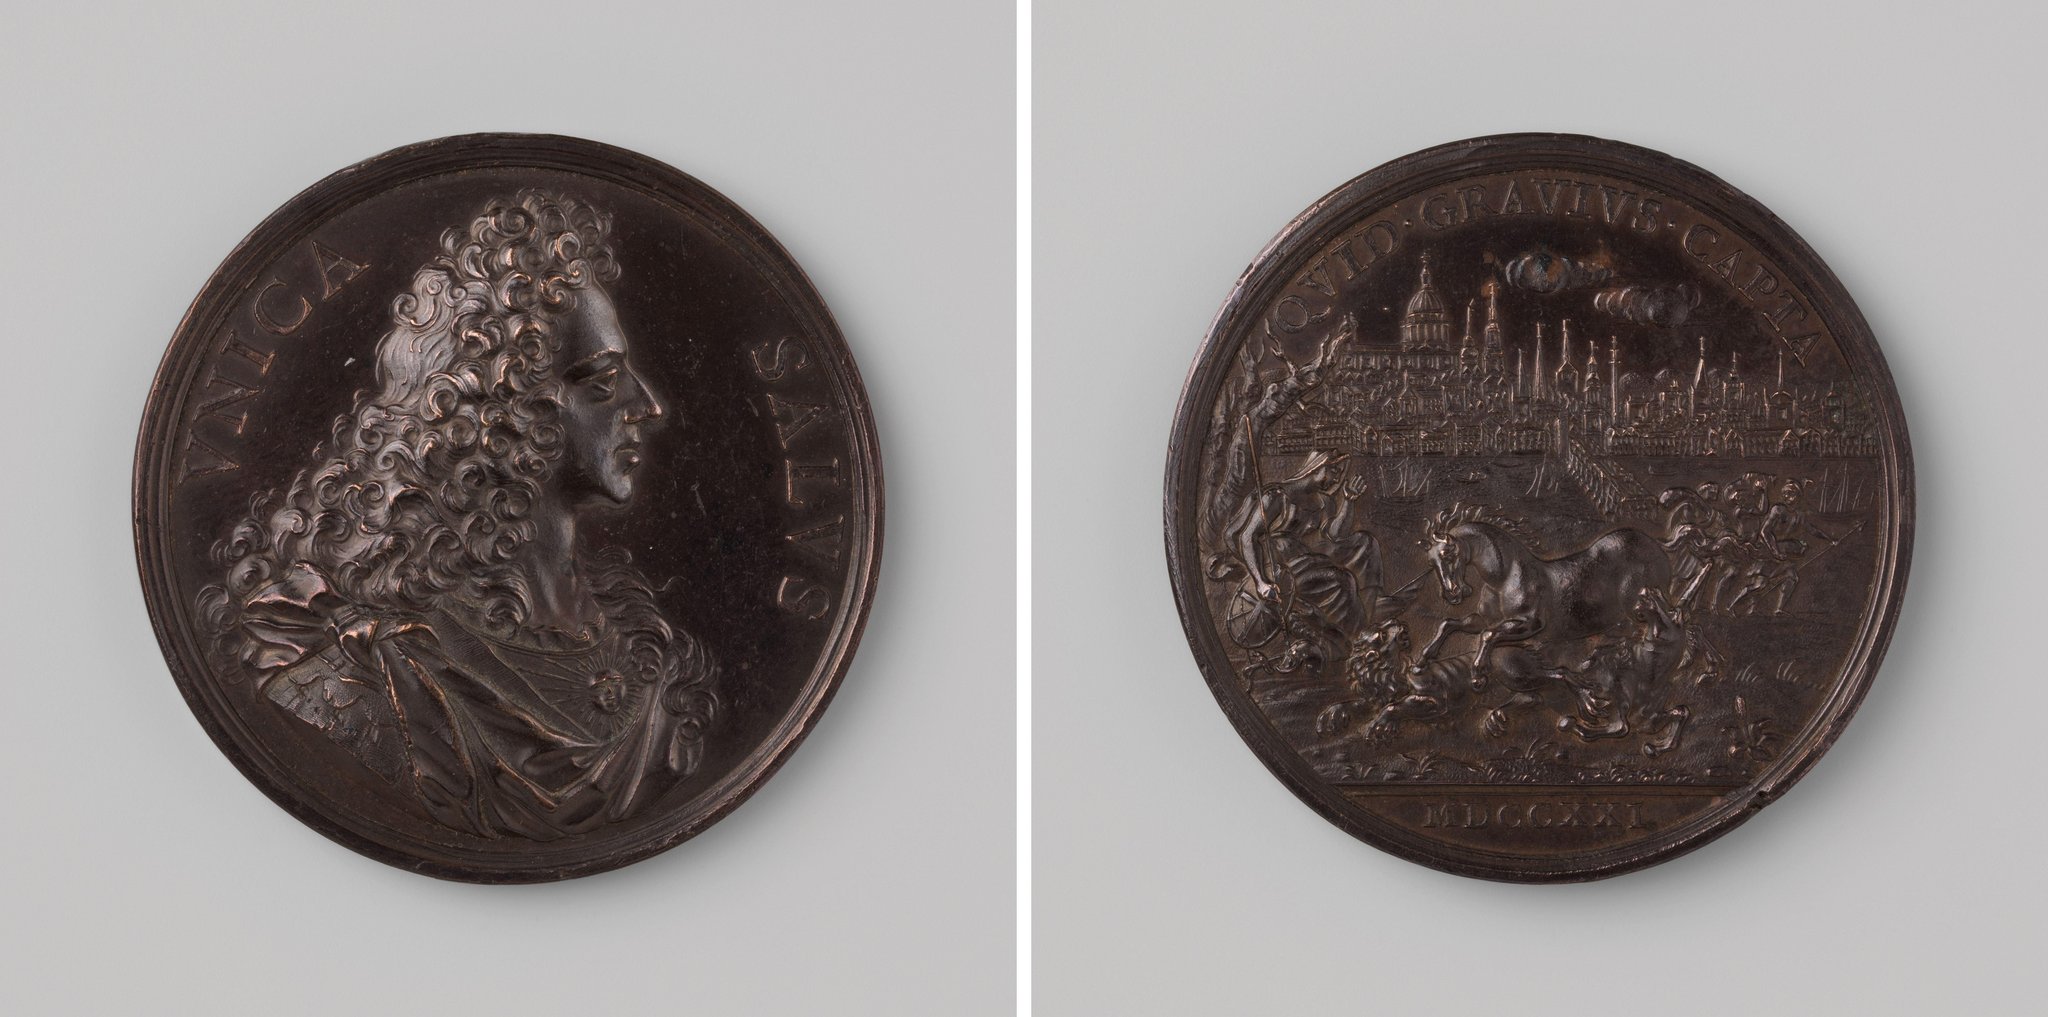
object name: history medal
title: Protest van Jacobus III Stewart, de 'Old Pretender' tegen de heerschappij van het huis van Hannover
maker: ottone hamerani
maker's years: 1694-1768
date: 1721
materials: bronze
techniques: striking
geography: rome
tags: rome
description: Bronzen penning. Voorzijde: borststuk man binnen omschrift. Keerzijde: het Hannoveraanse paard vertrapt leeuw en eenhoorn, onder het toeziend oog van treurende Britannia, op achtergrond gezicht op stad Londen binnen omschrift; afsnede: opschrift.